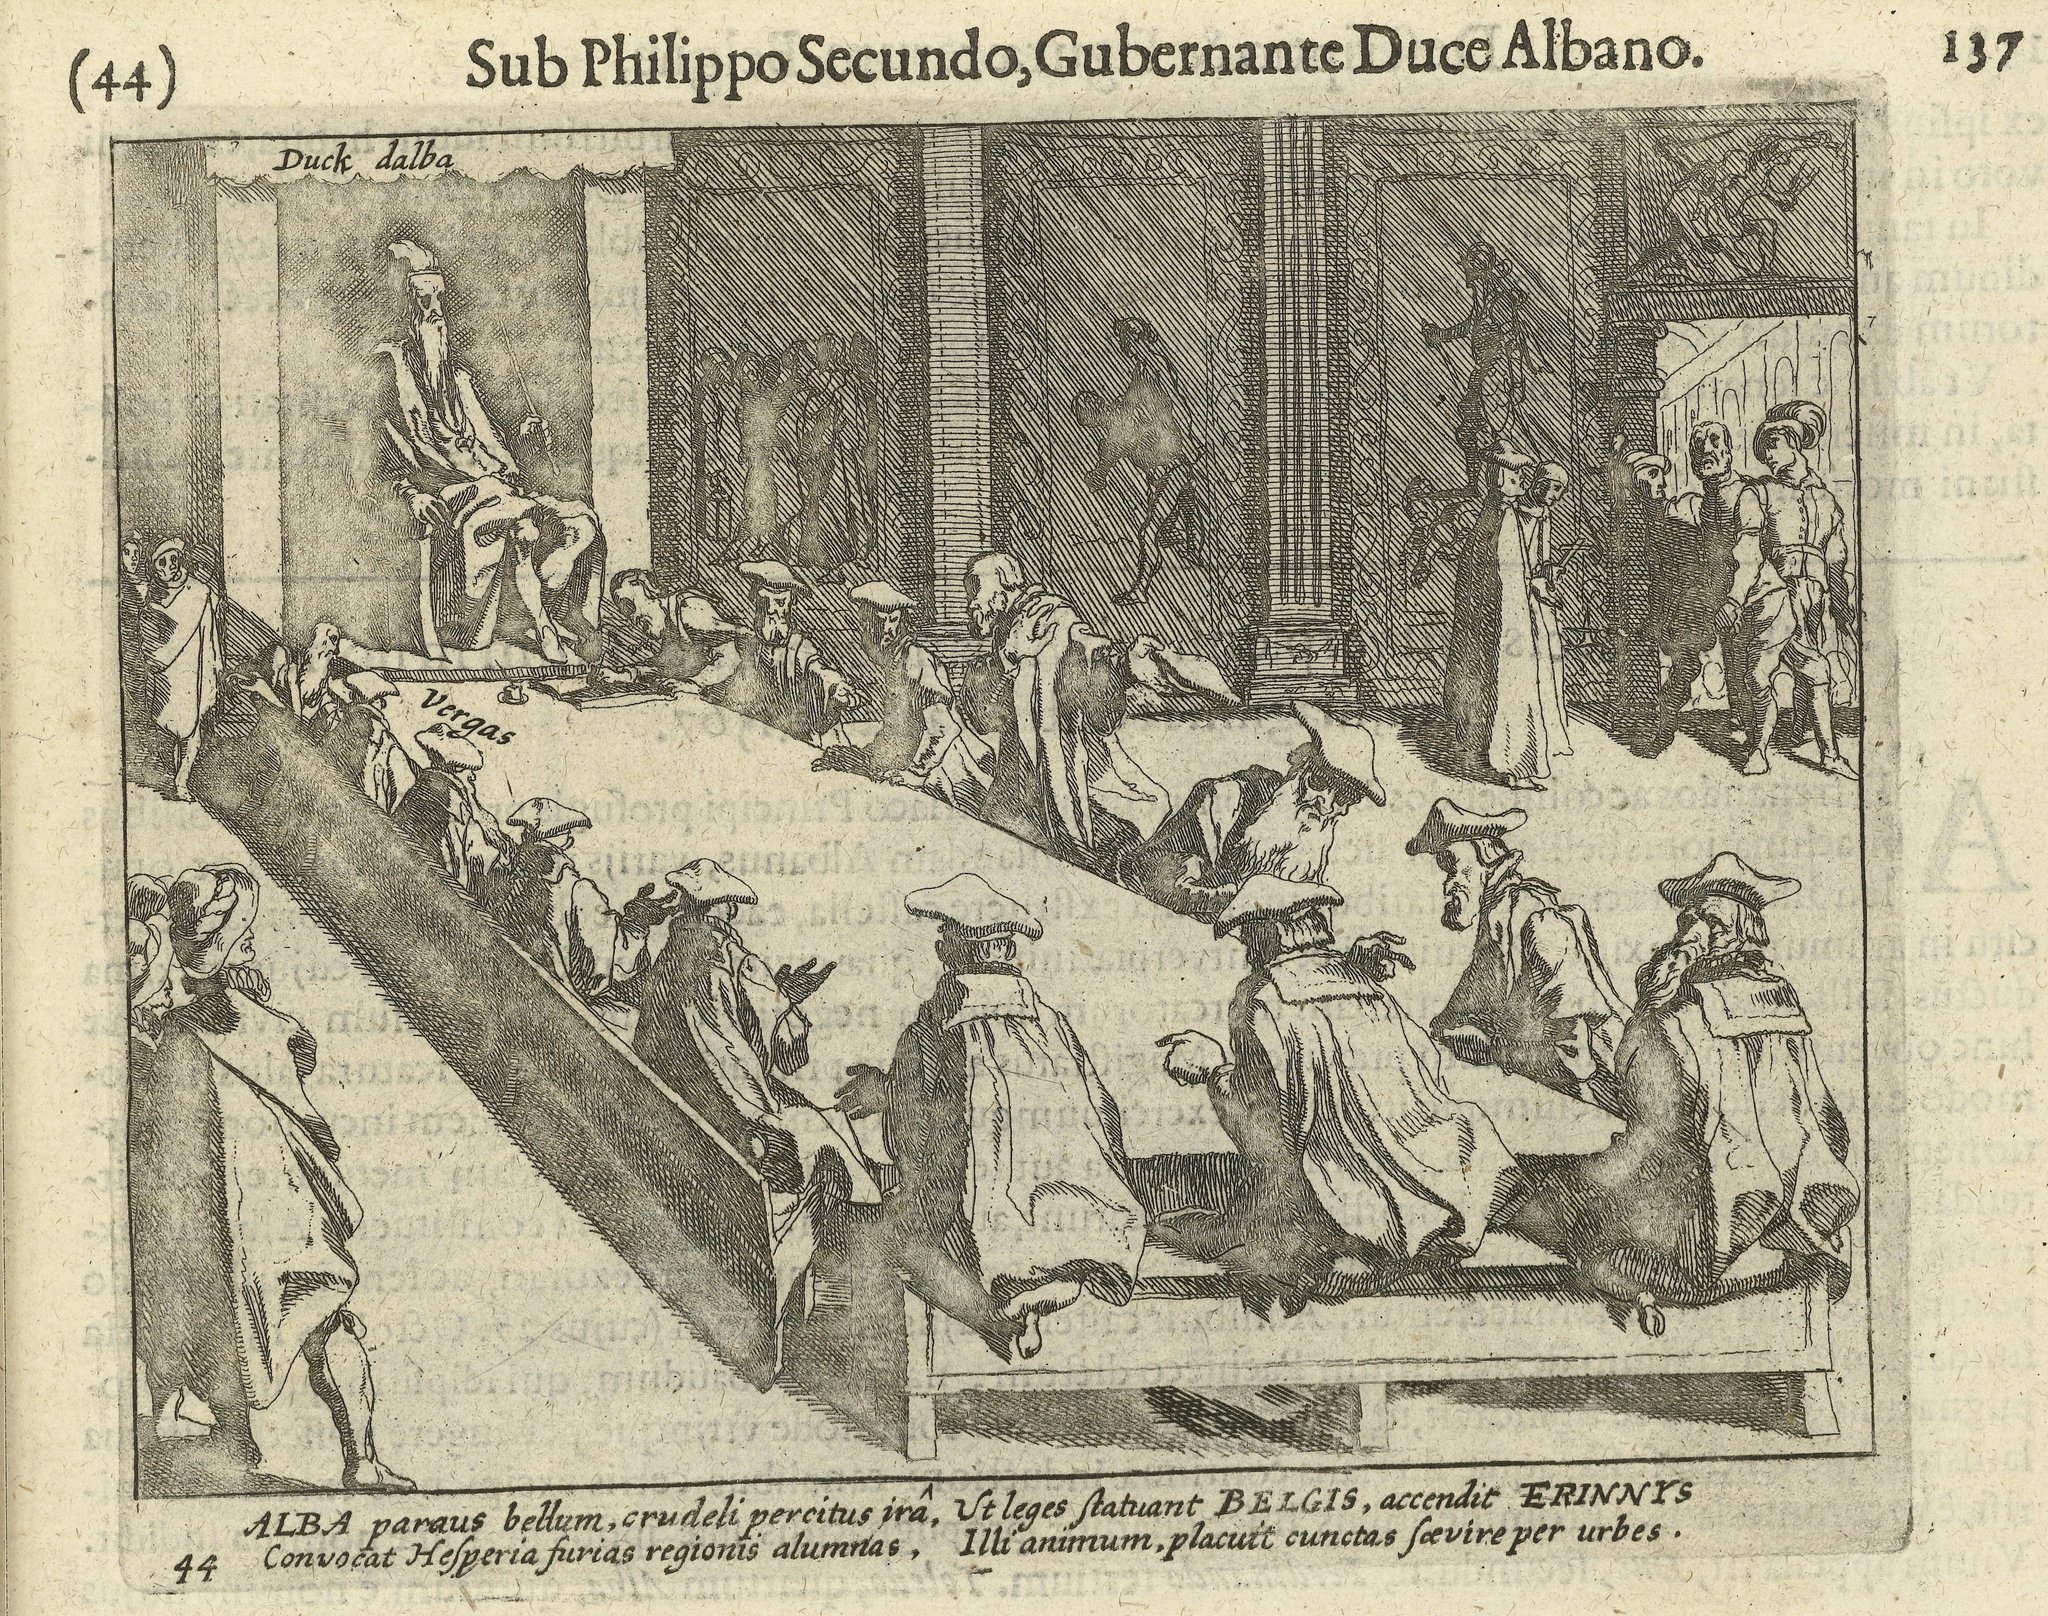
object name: history print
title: Zitting van de Spaanse Bloedraad, 1567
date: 1613-1615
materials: paper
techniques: etching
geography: amsterdam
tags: fernando álvarez de toledo (3rd duke of alba), court session (court of justice)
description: Zitting van de Raad van Beroerten, bijgenaamd de Bloedraad, voorgezeten door de hertog van Alva gezeten op een troon met de gerechtsroede in de hand, 1567. Aan de muren van het interieur hangen wandkleden. Met onderschrift van 4 regels in het Latijn. Genummerd: 44. Bedrukt op achterzijde met tekst in het Latijn.